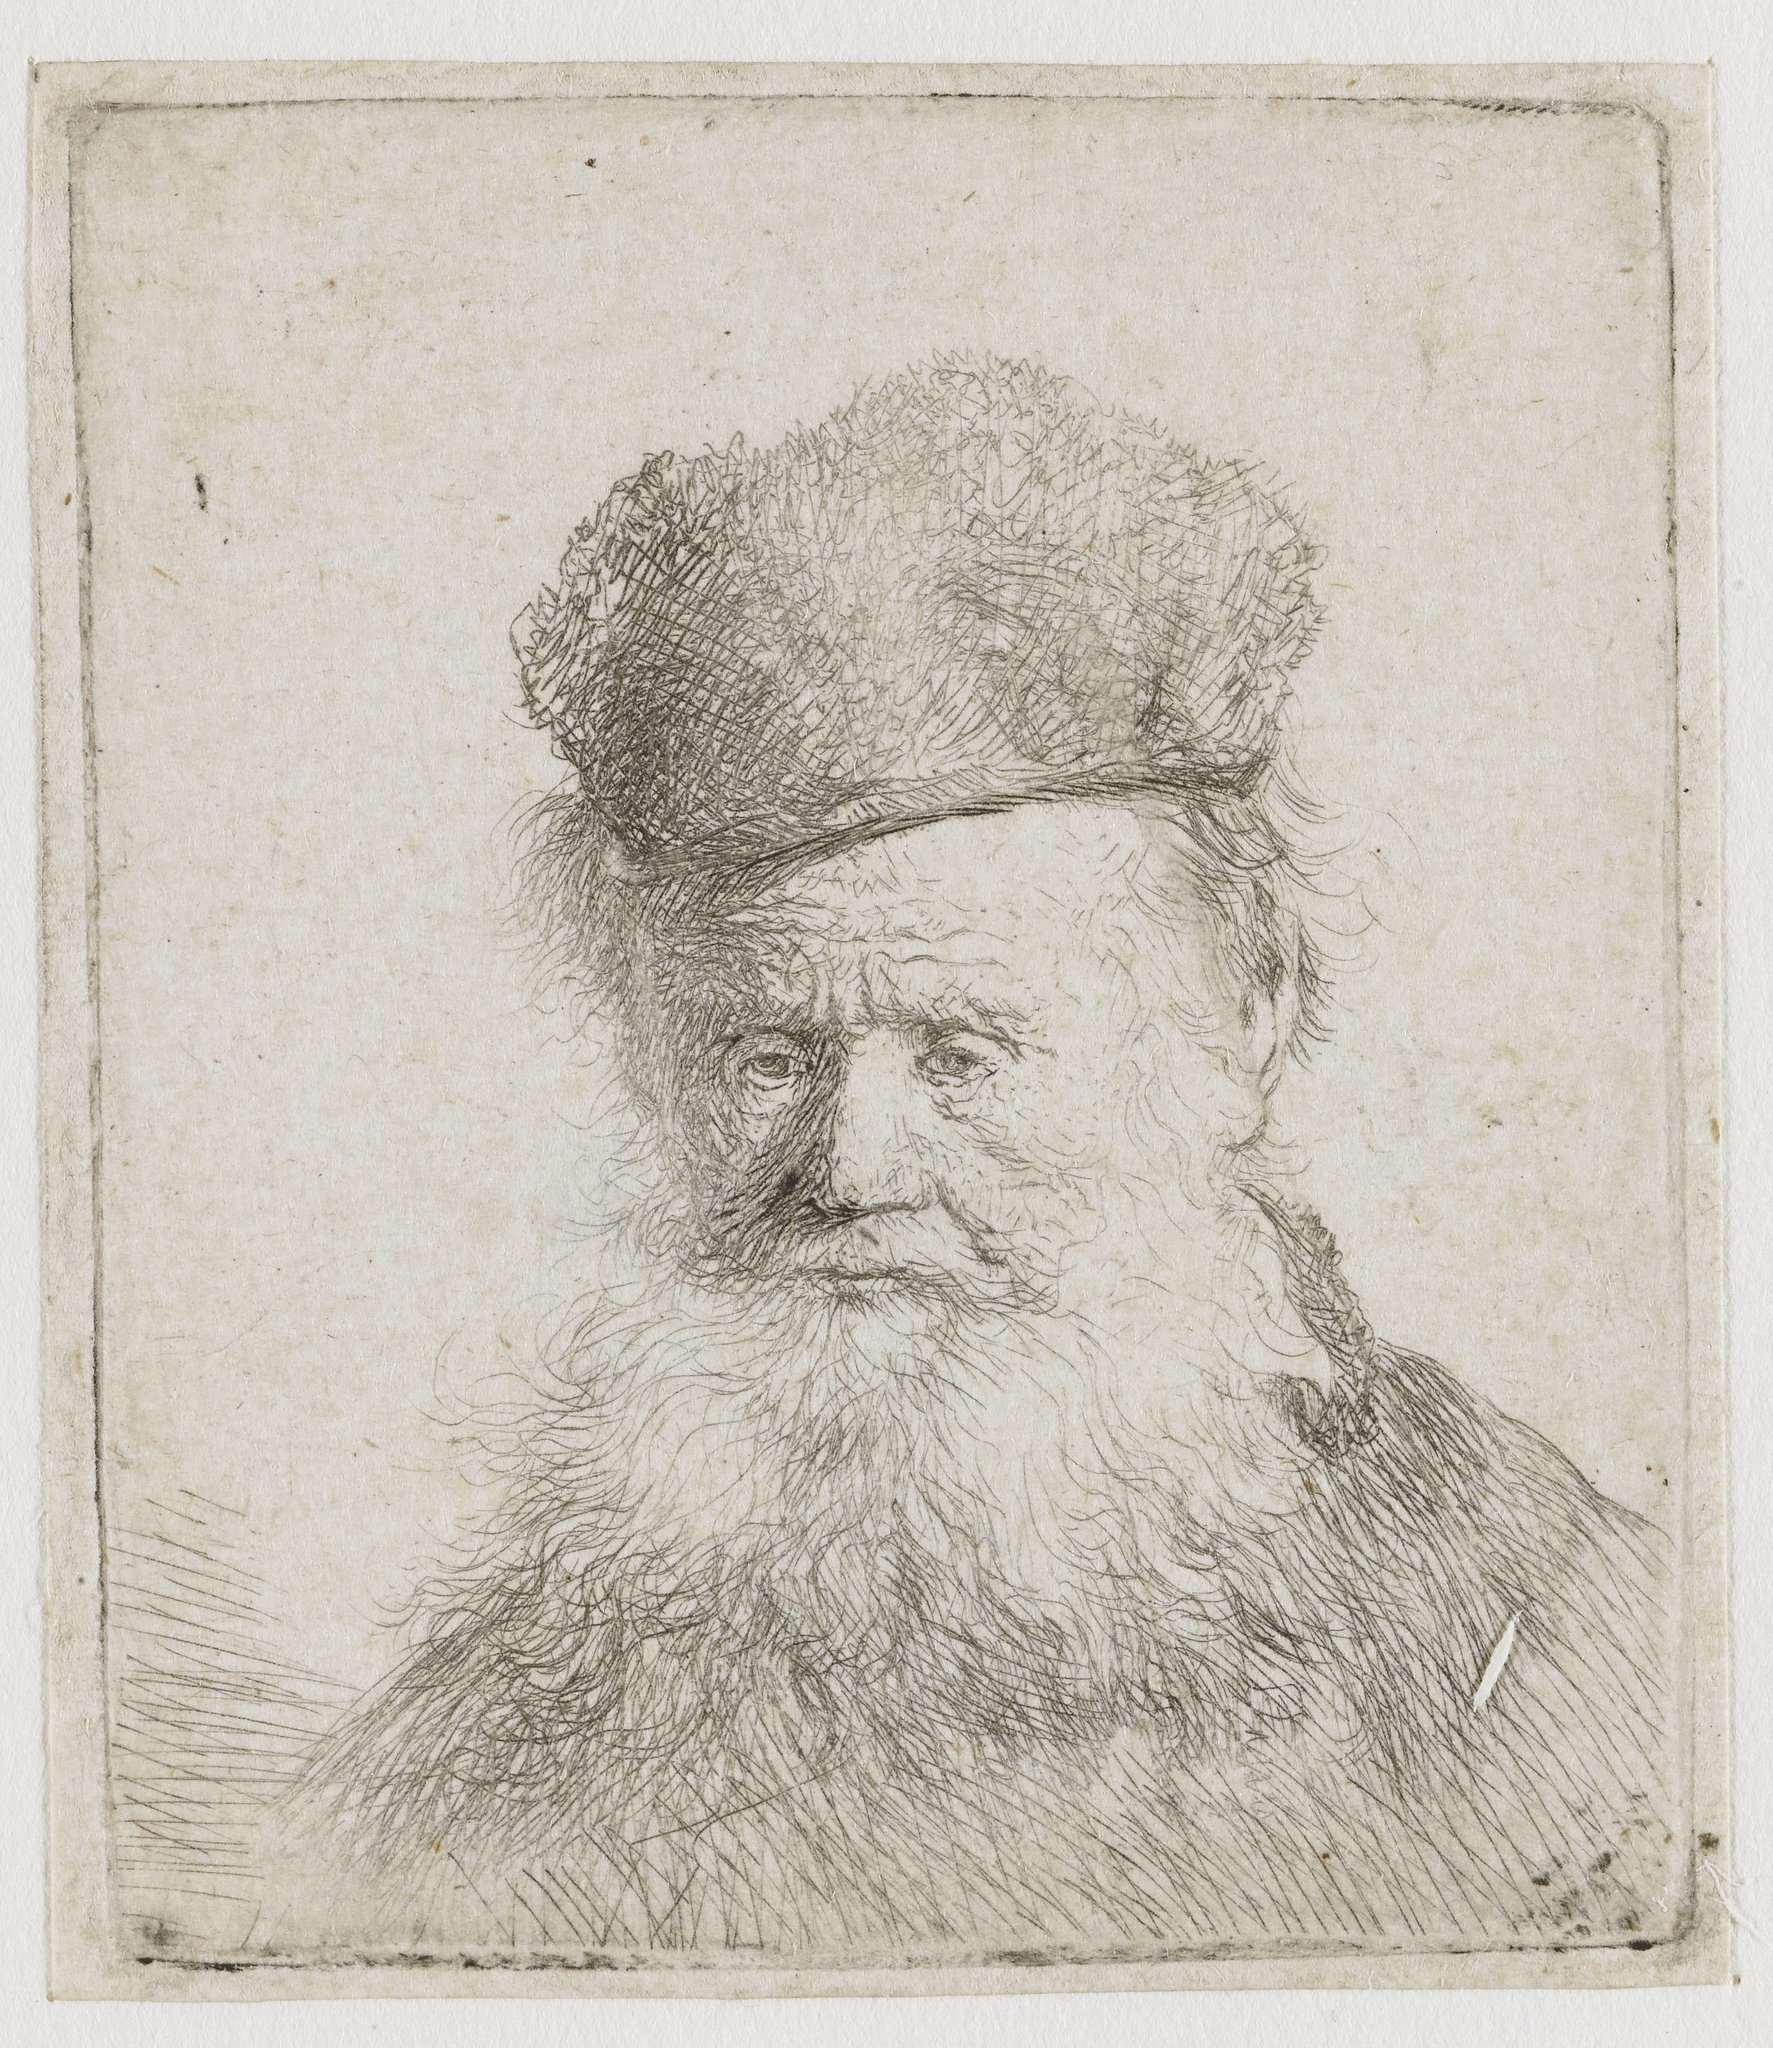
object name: print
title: Bust of an old man with a fur cap and flowing beard, nearly full face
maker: rembrandt van rijn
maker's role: draughtsman, painter, print maker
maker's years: 1606-1669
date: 1631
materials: paper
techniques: etching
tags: head-gear (with name)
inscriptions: mark: Lugt 2681 a, mark: ‘russische tekst’, mark: Lugt 2228